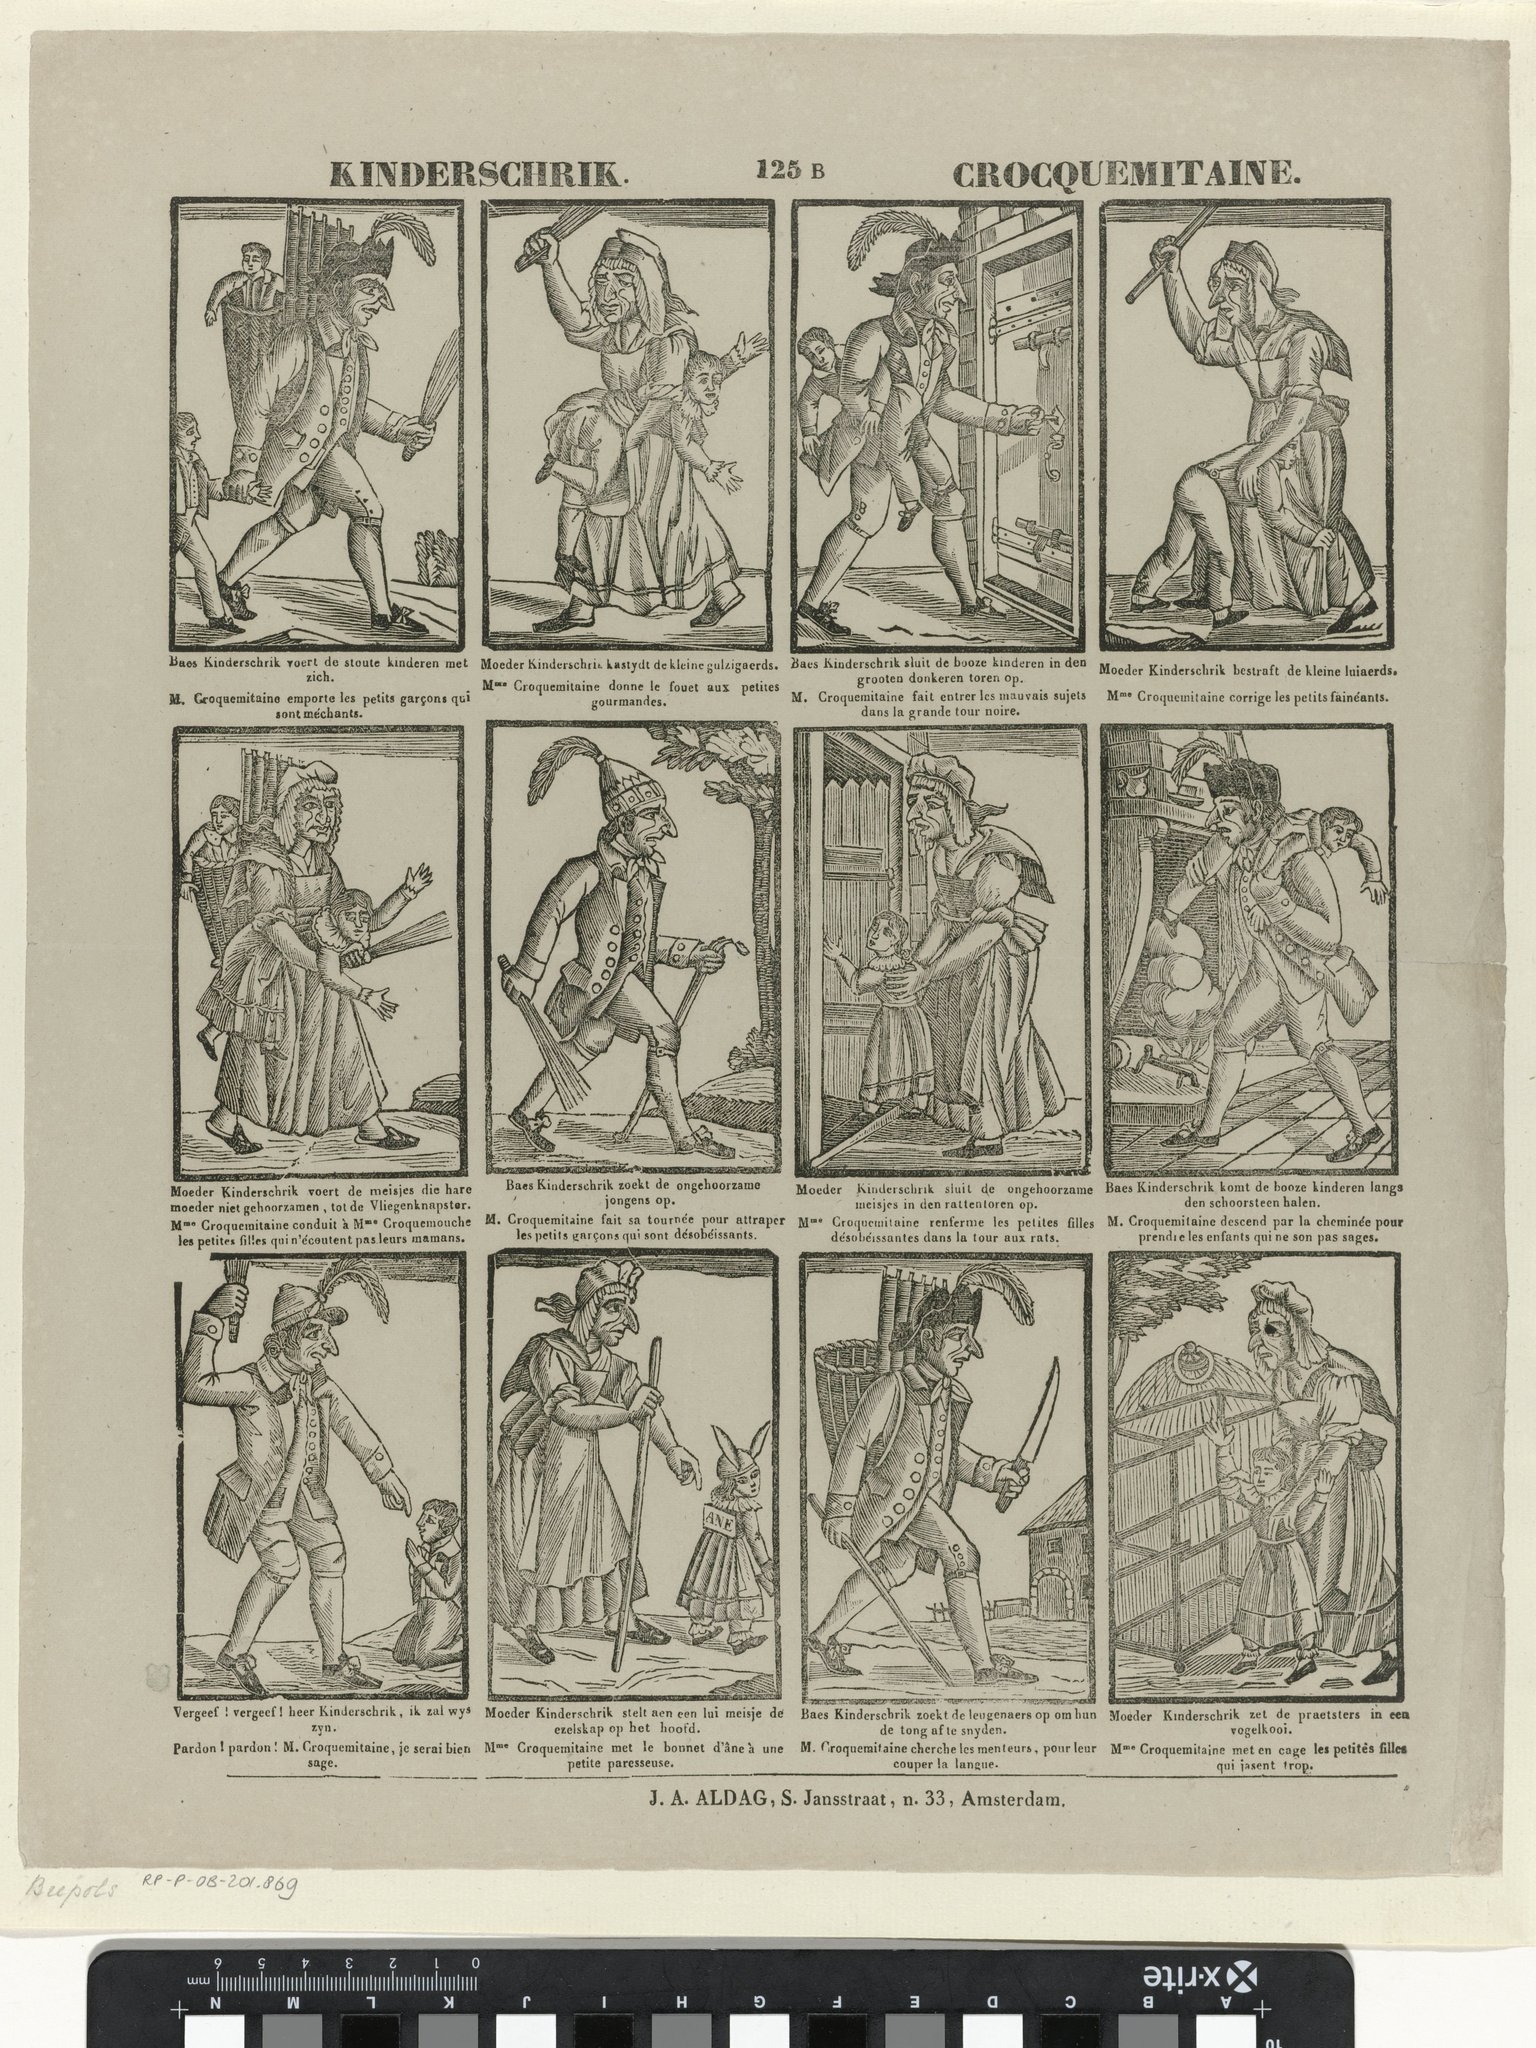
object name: popular print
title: Kinderschrik / Crocquemitaine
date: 1851-1880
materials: paper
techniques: letterpress printing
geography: amsterdam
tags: bogey-man, bugaboo - aa - girl, bogey-man, bugaboo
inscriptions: collector's mark: Lugt 2760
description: Blad met 12 voorstellingen van meneer en mevrouw Croquemitaine, de Franse boemannen die kinderen angst aanjagen. Onder elke afbeelding een onderschrift in het Nederlands en in het Frans. Genummerd midden boven: 125B.